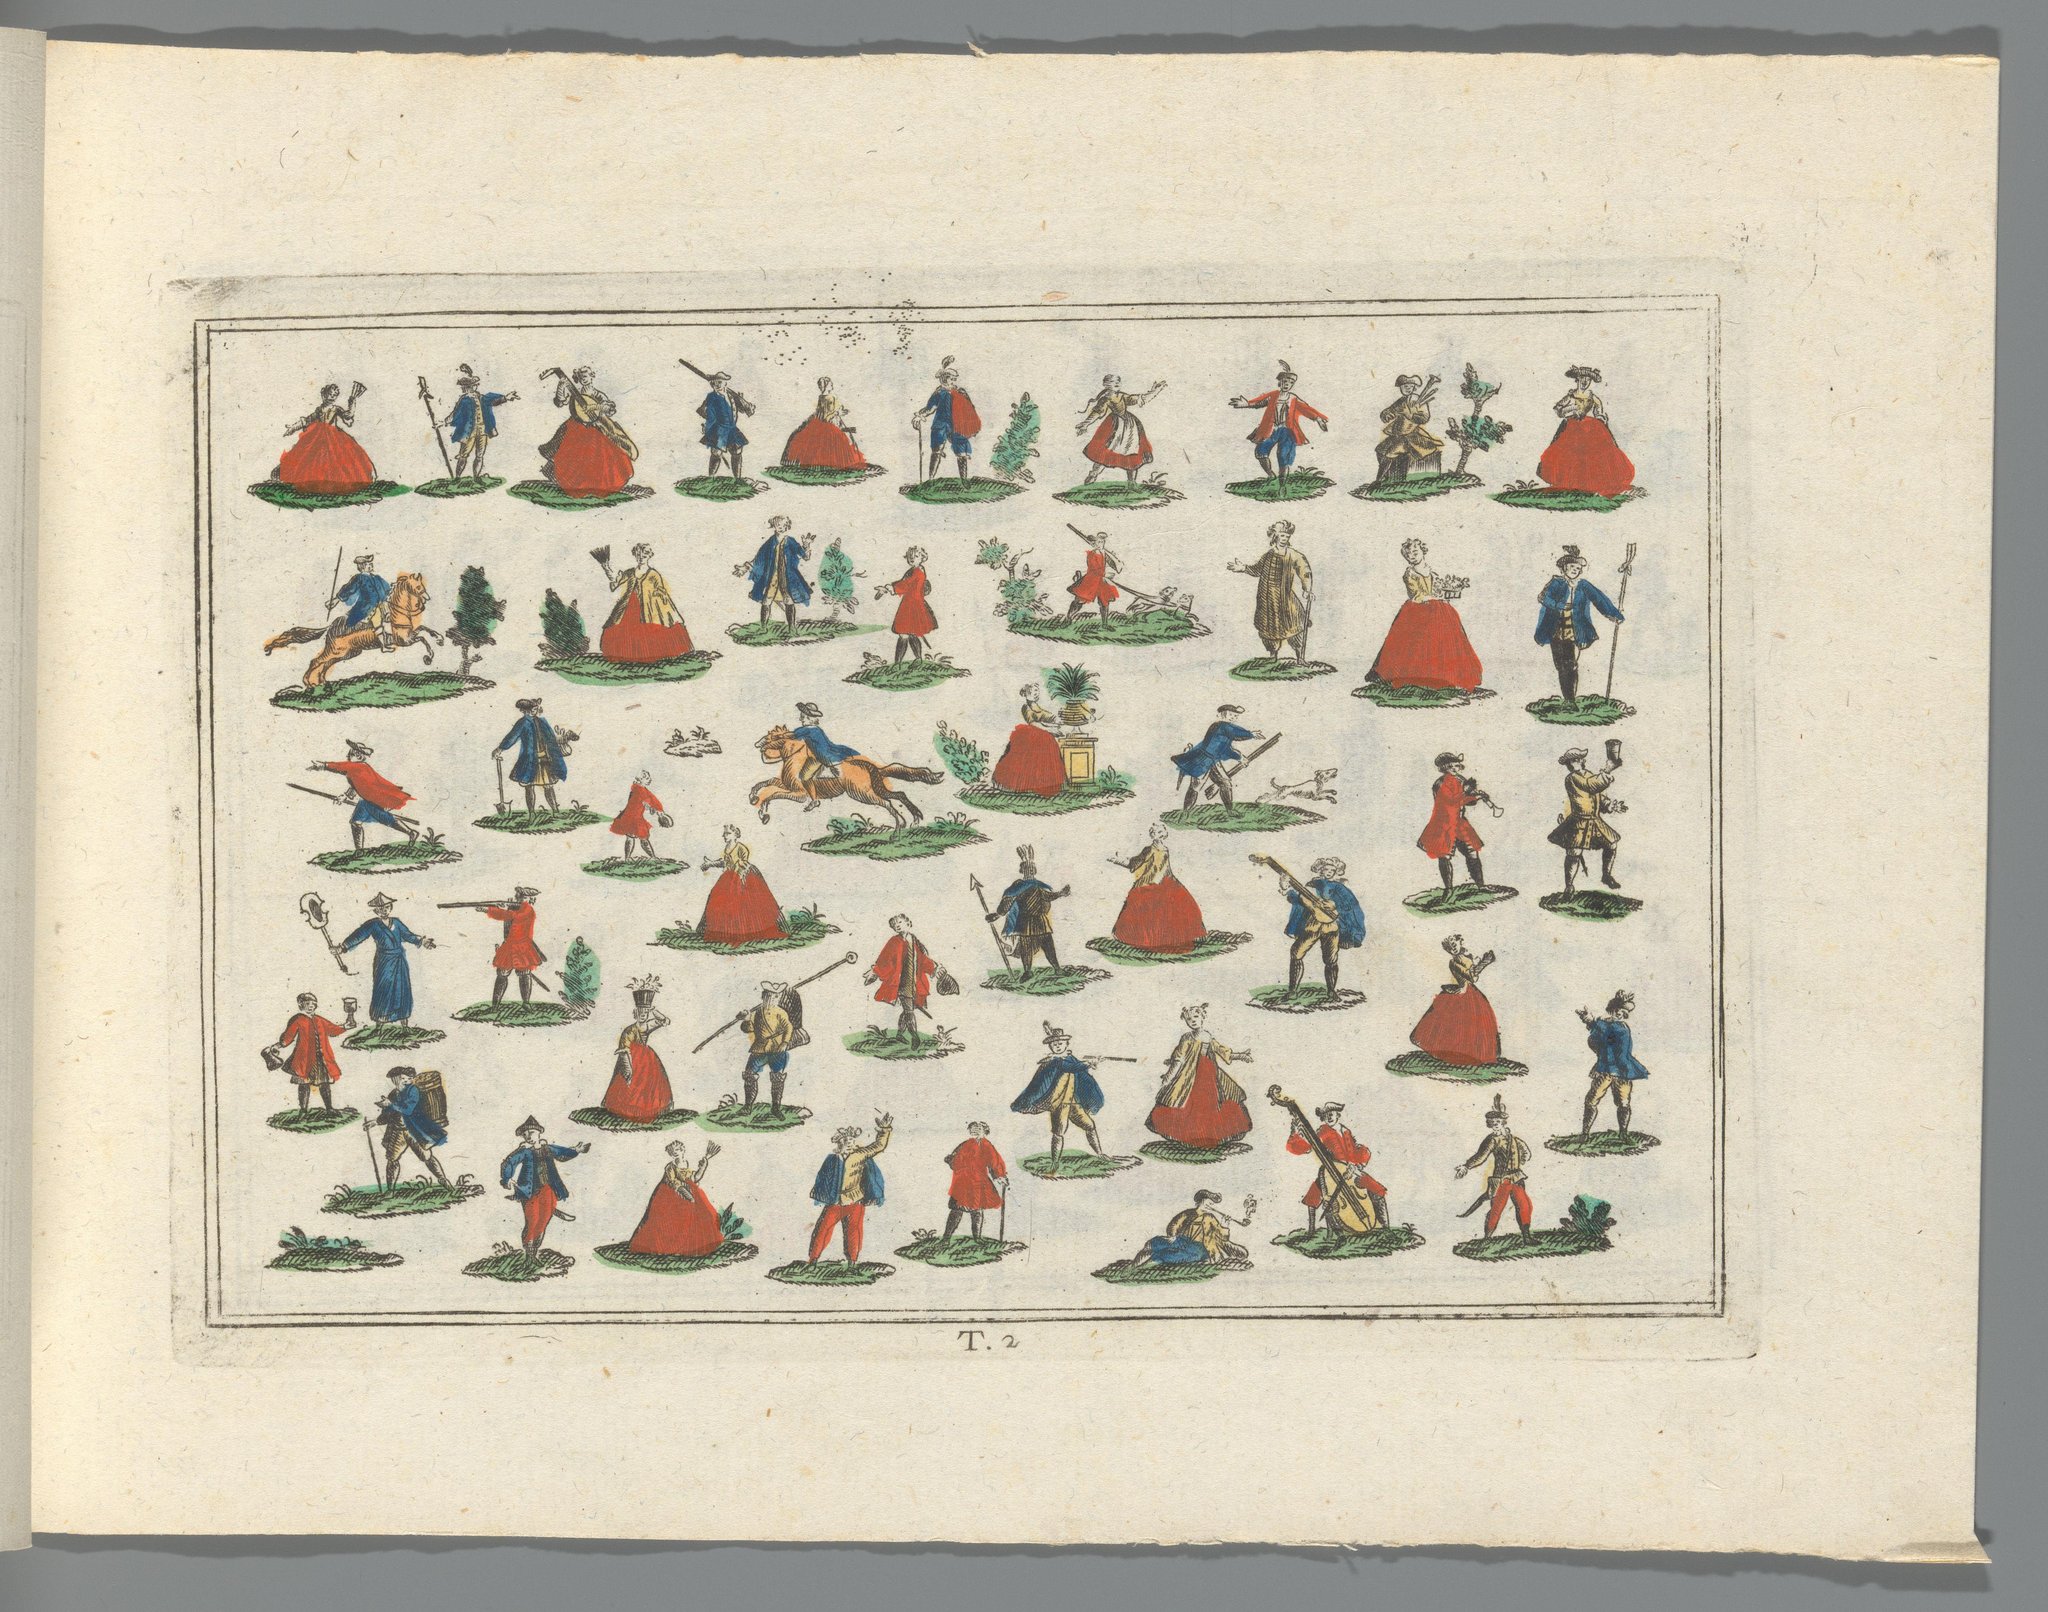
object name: print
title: Dames en heren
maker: Anonymous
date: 1750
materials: paper, watercolor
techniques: etching, hand coloring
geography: paris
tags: adult woman, adult man, clothes, costume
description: Blad met galante dames en heren, in verschillende bezigheden. Midden onder genummerd: T. 2. Een van 39 bladen met knipplaatjes en decoratieve randen.